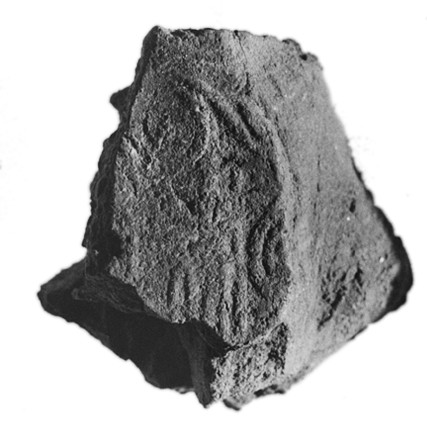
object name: sealing fragment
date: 2030-1640 BCE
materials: clay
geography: egypt